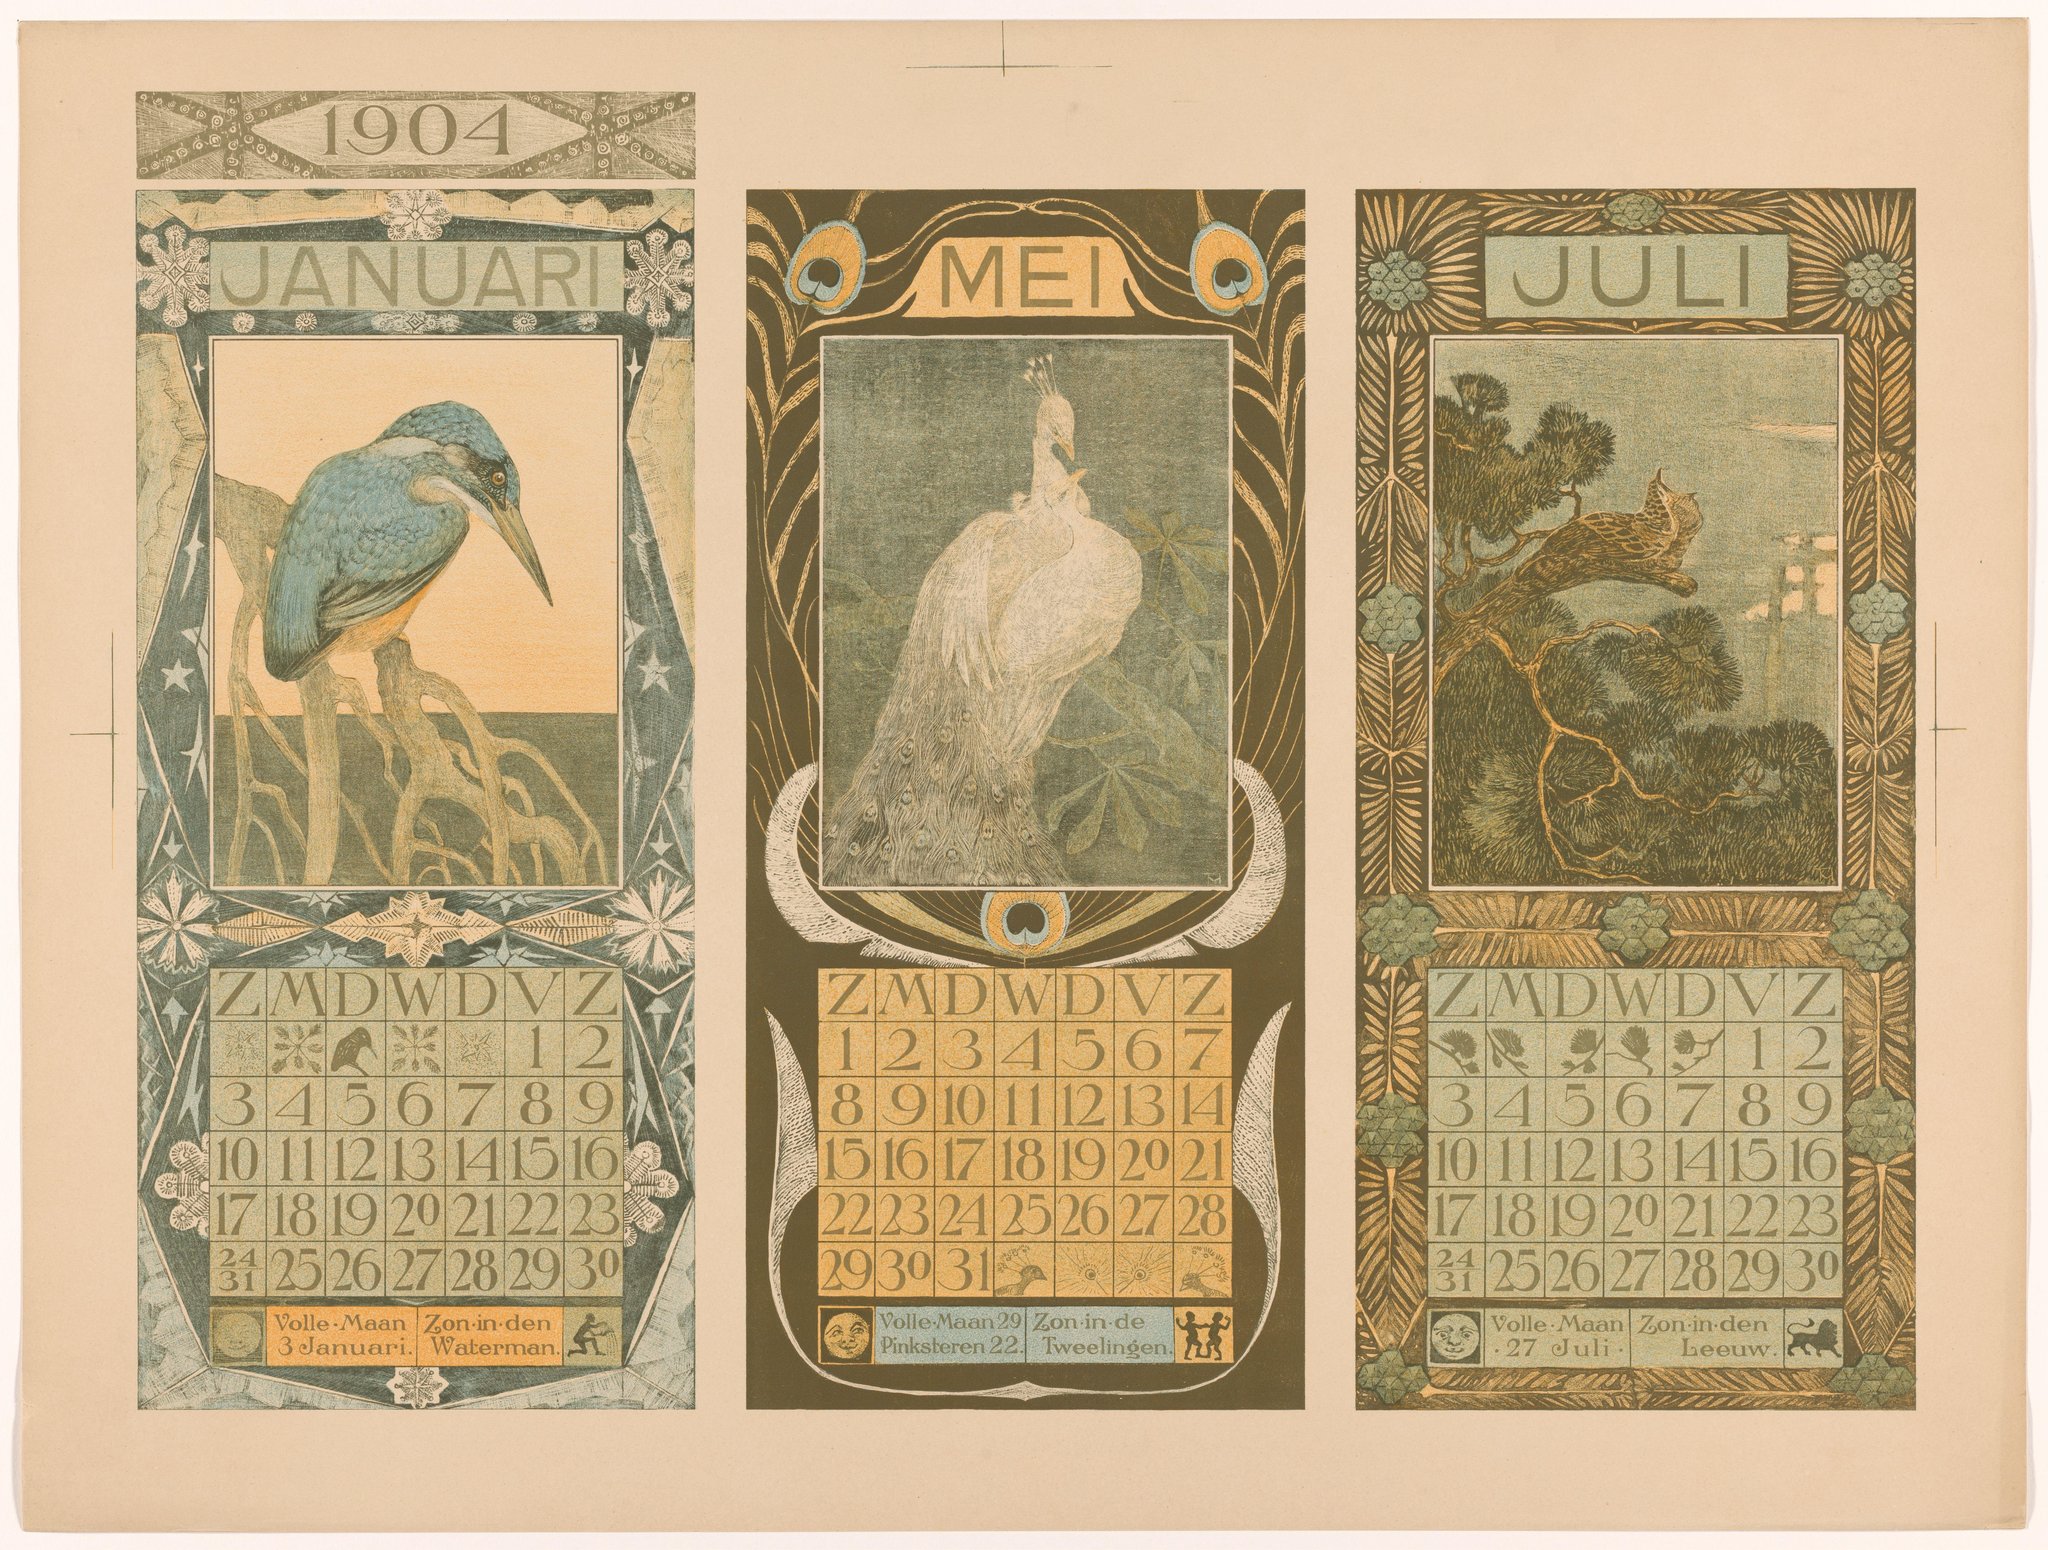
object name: print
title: Kalenders voor januari, mei en juli 1904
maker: theo van hoytema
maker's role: draughtsman, painter, print maker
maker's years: 1863-1917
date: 1904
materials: paper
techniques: lithograph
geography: amsterdam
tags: calendar, almanac, song-birds: swallow, ornamental birds: peacock, other birds: kingfisher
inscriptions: collector's mark: Lugt 2233